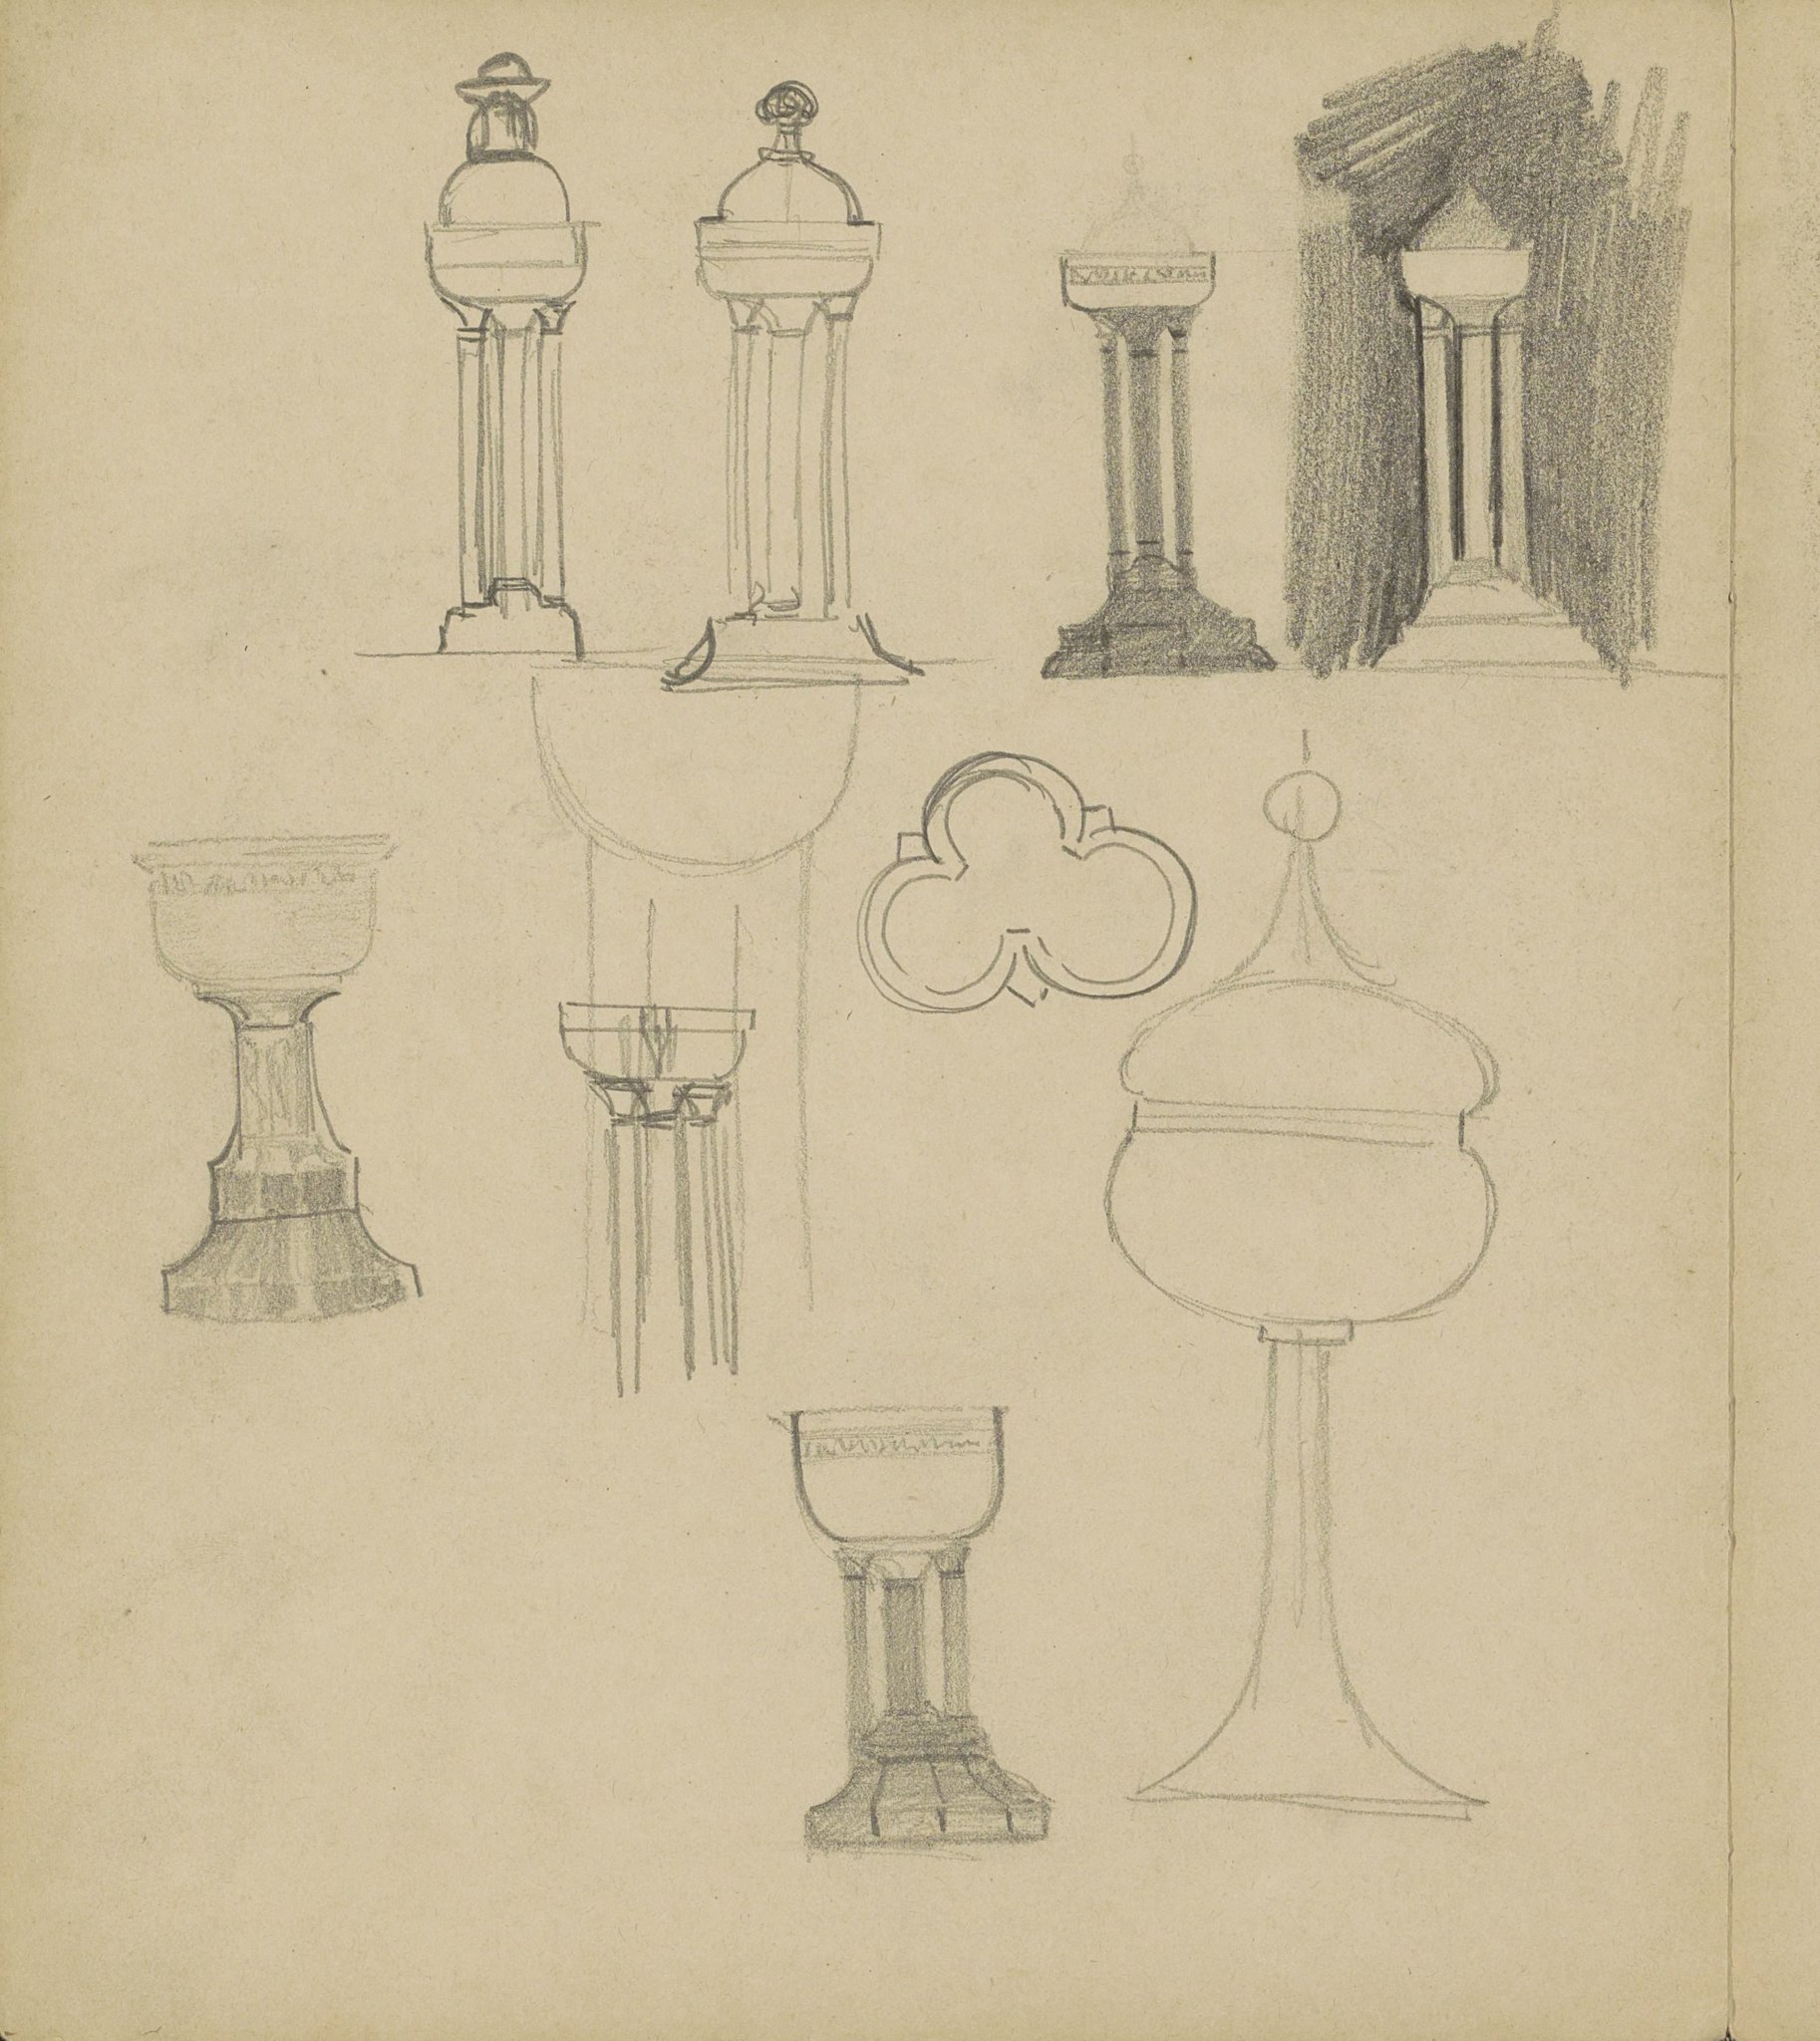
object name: sketchbook leaf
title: Ontwerpen voor een doopvont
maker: carel adolph lion cachet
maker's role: draughtsman, print maker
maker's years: 1864-1945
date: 1905-1906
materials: paper, pencil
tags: baptismal font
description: Blad 3 verso uit een schetsboek met 30 bladen.